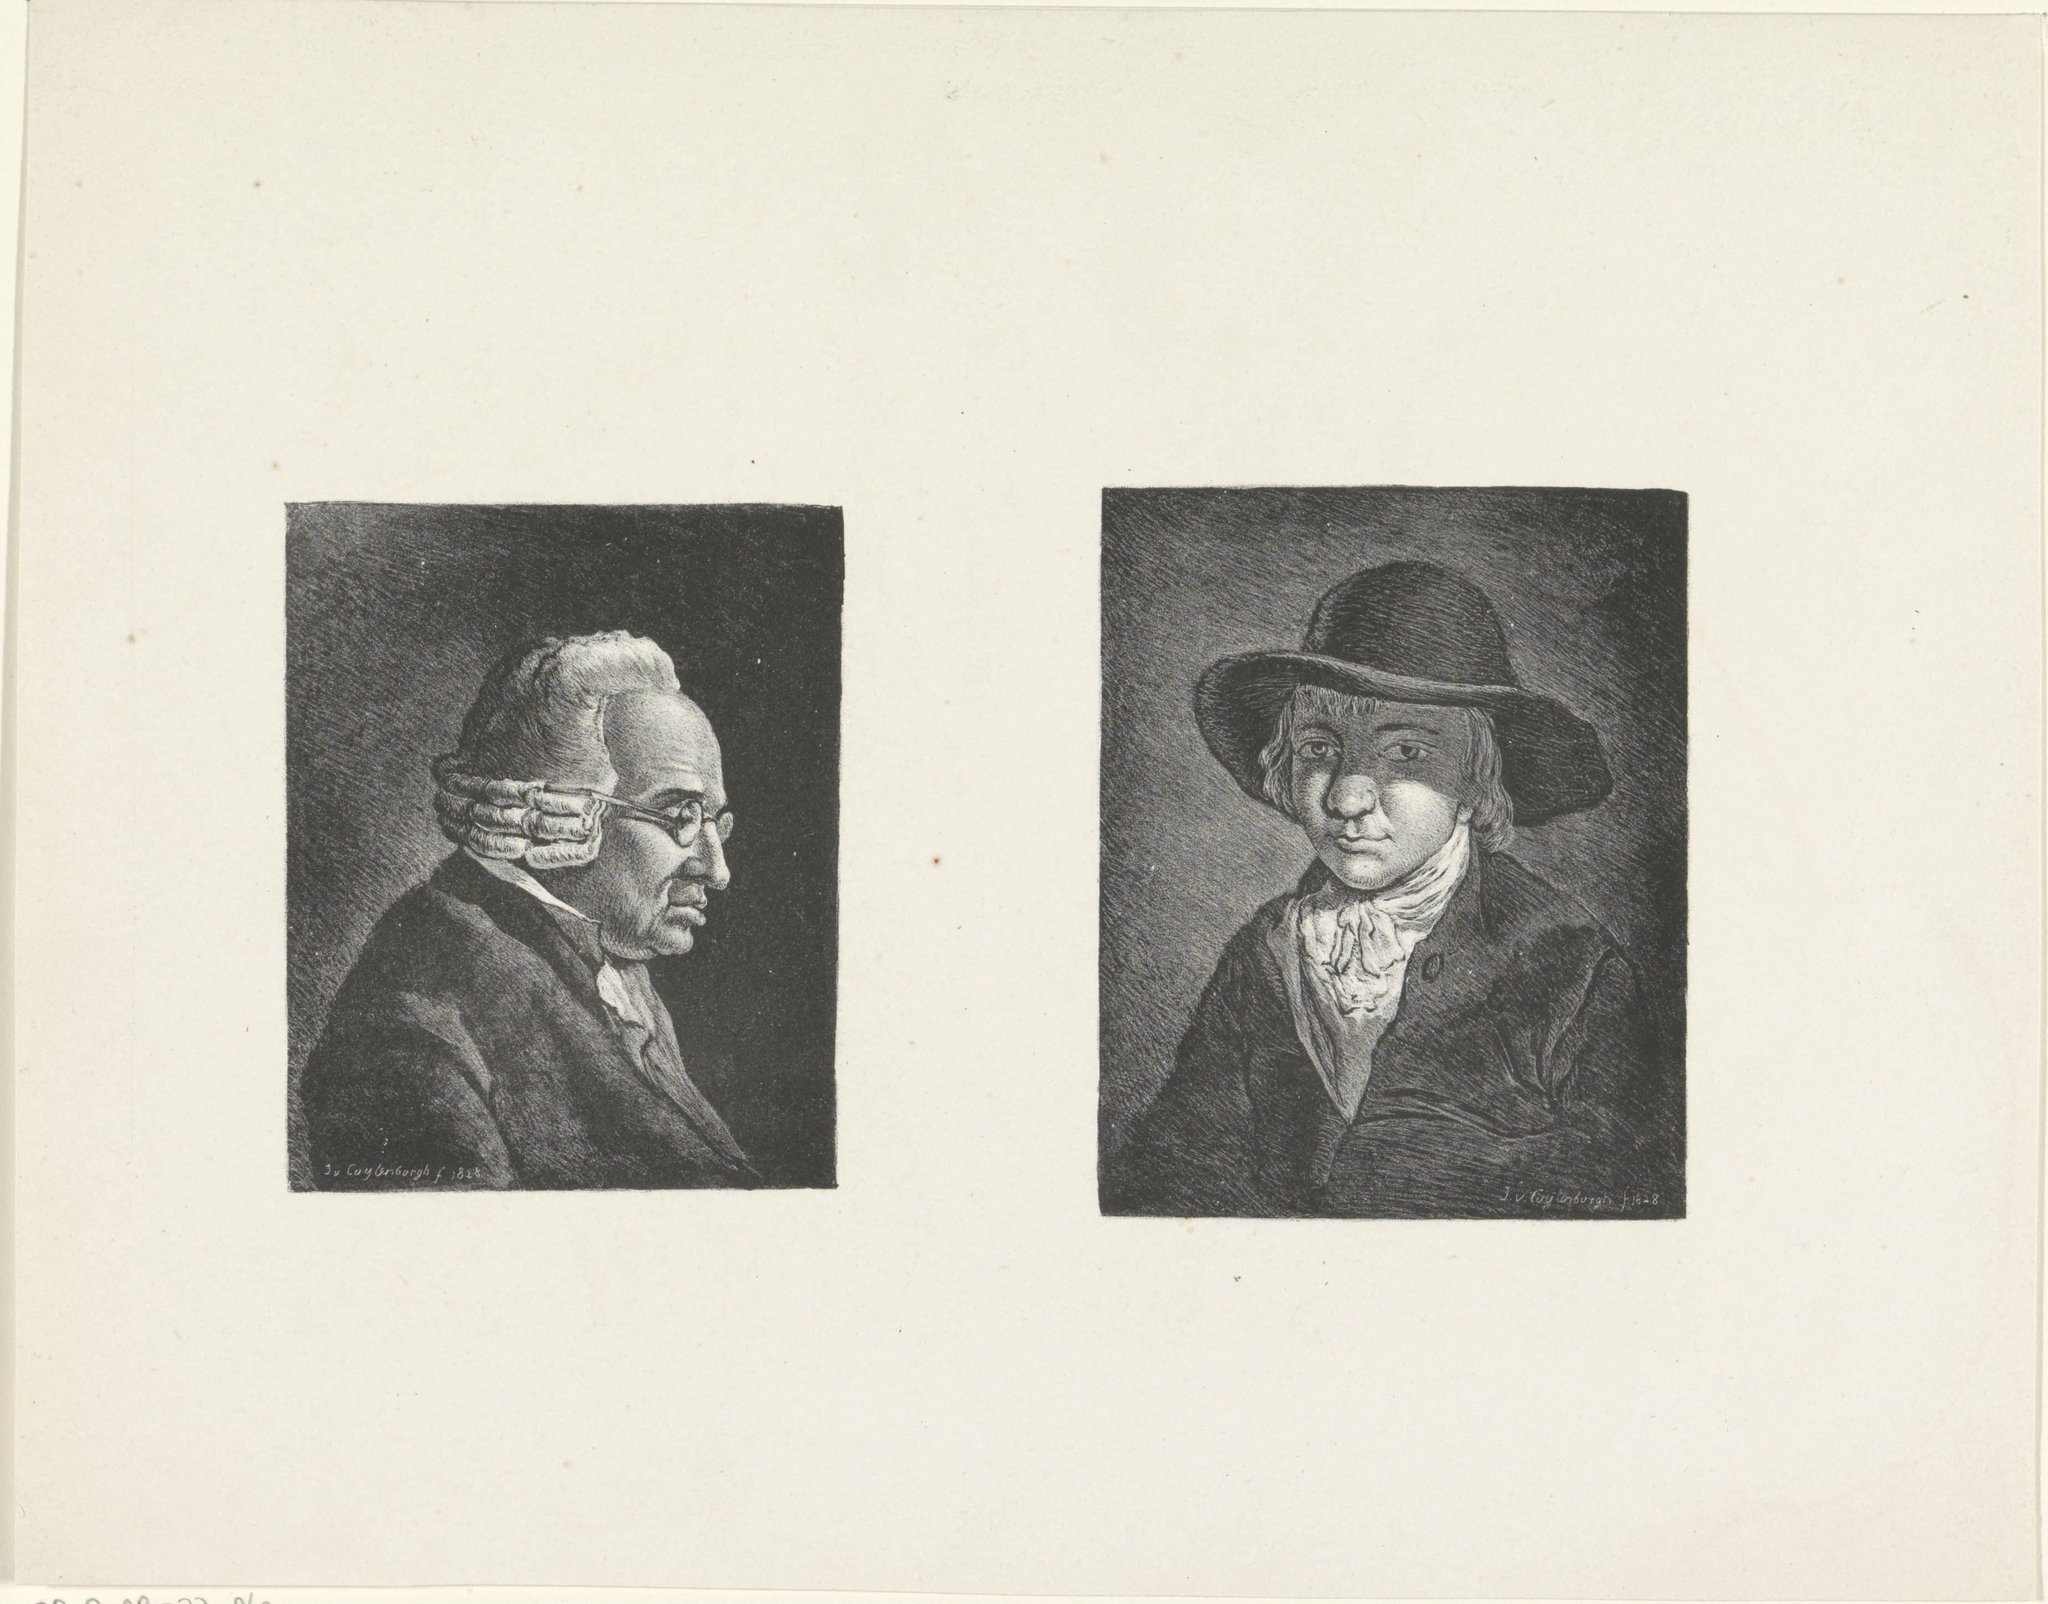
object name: print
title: Twee mannen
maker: johannes van cuylenburgh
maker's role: print maker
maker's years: 1793-1841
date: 1828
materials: paper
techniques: lithograph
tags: wig (+ sideview, profile), eyeglasses, spectacles, anonymous historical person portrayed (+ profile portrait), anonymous historical person portrayed (+ head (and shoulders) (portrait)), head-gear: hat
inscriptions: date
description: Een man draagt een bril en pruik. Hij kijkt naar rechts en is en profil afgebeeld. De jongere man draagt een hoed.